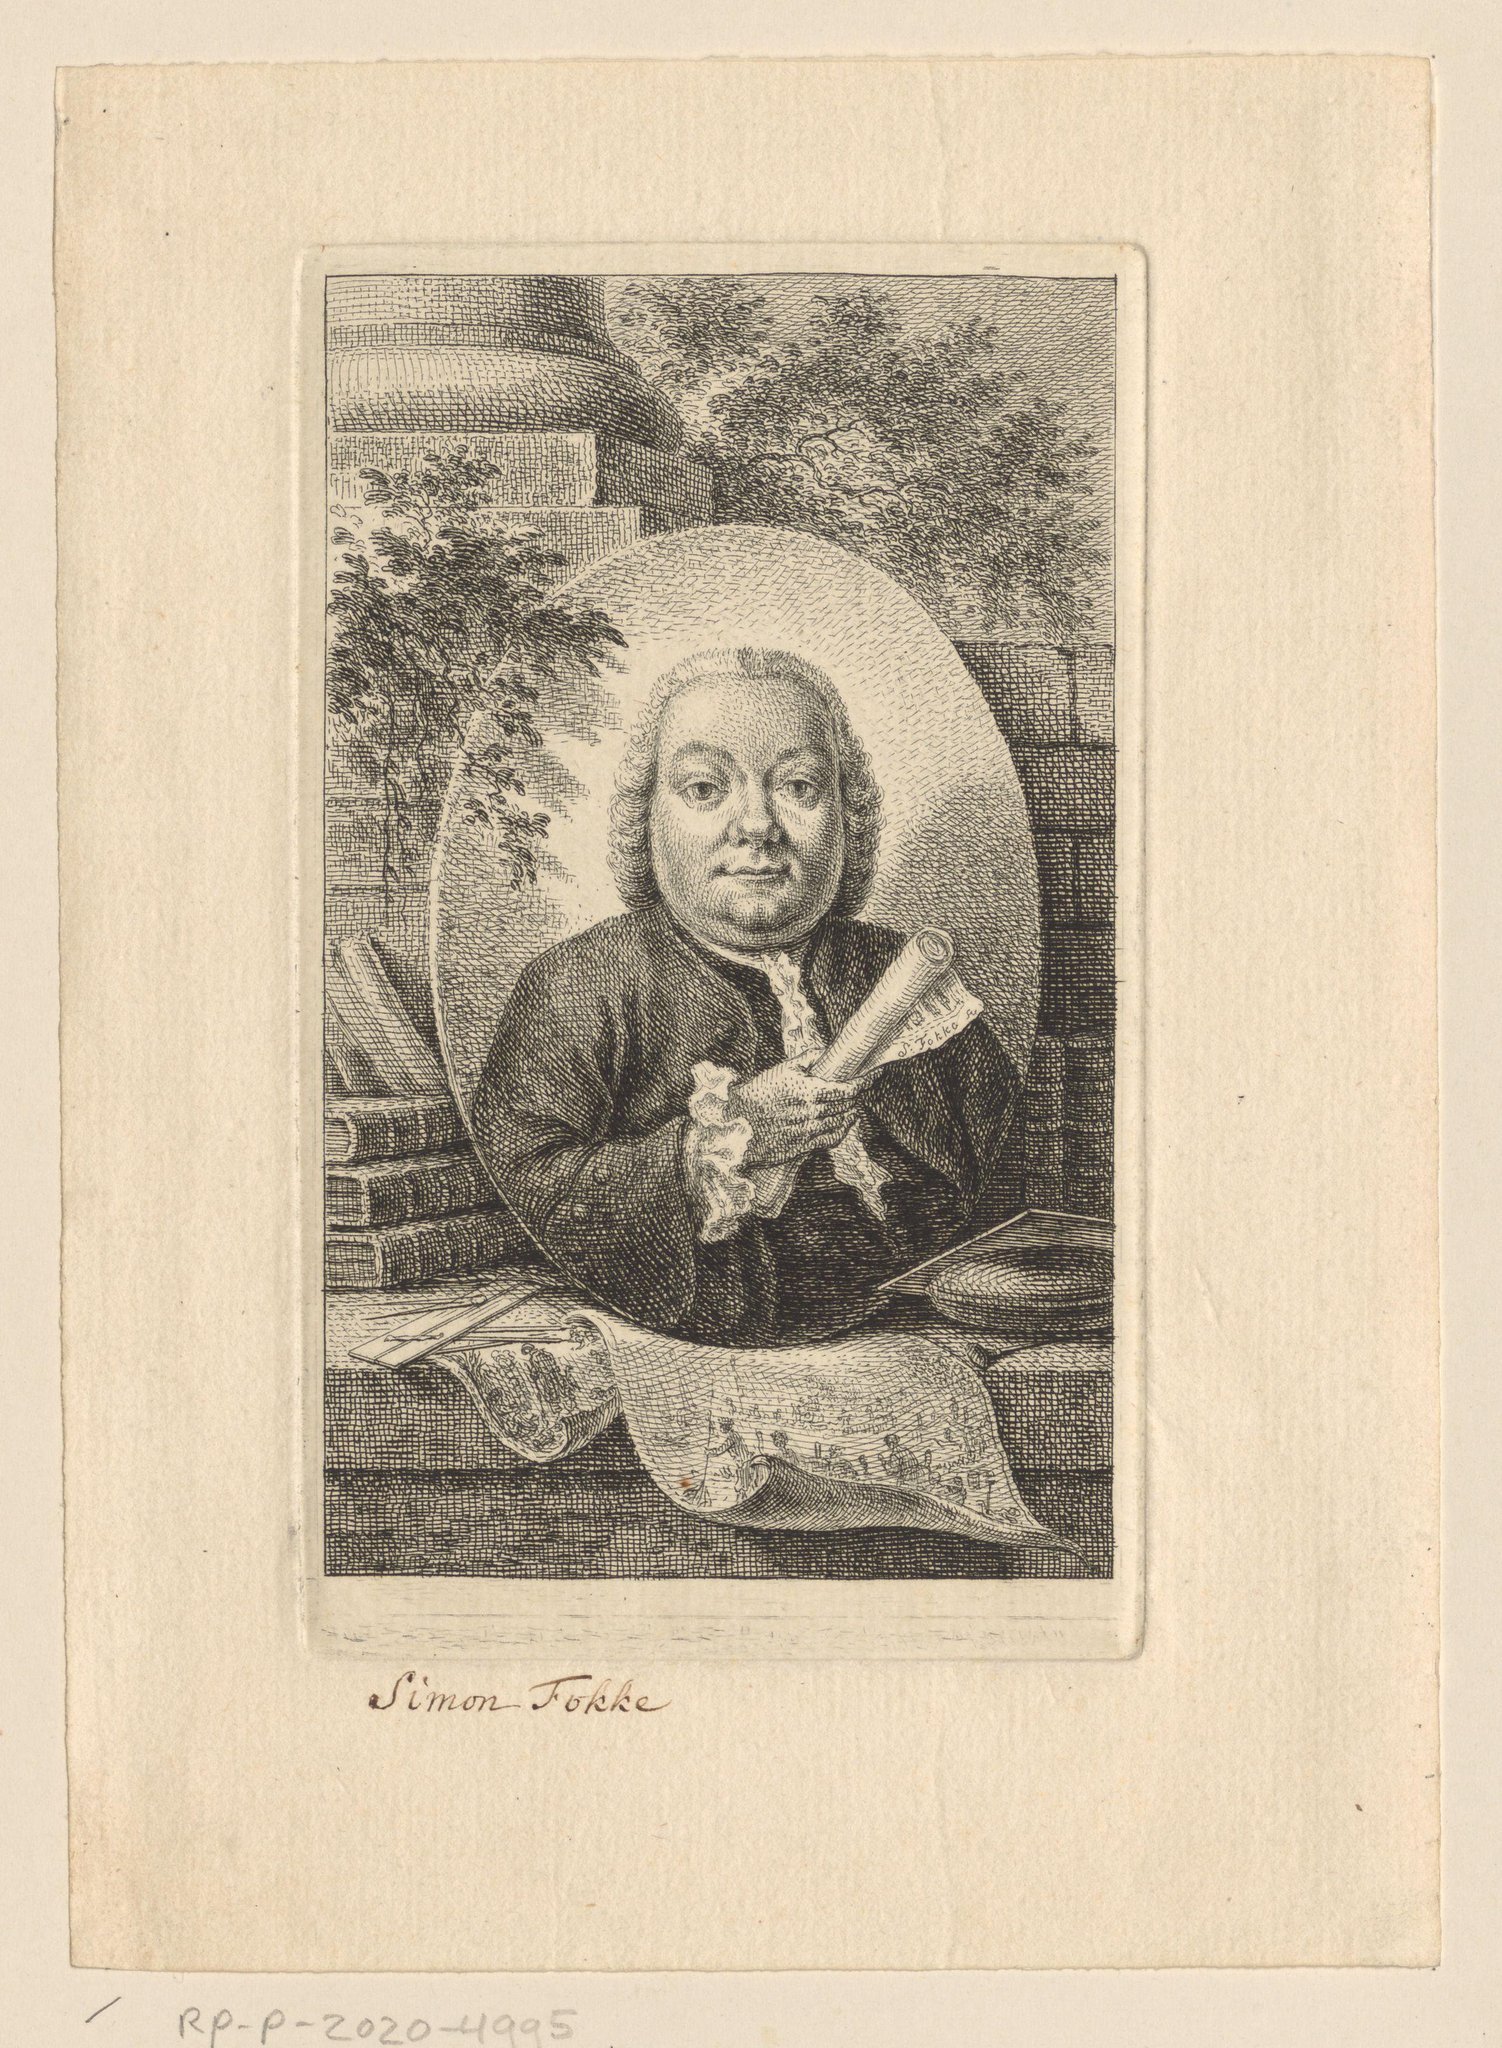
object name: print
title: Zelfportret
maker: simon fokke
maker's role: draughtsman, print maker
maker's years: 1712-1784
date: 1740-1784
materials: paper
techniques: etching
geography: amsterdam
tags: amsterdam, print maker, draughtsman, simon fokke, historical persons, portrait, self-portrait of graphic artist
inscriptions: inscription: ‘Simon Fokke’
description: Zelfportret van Simon Fokke met een rol papier in zijn handen. De portretbuste in ovaal steunt tegen een muur en wordt omringd door boeken, graveergereedschap en twee prenten.